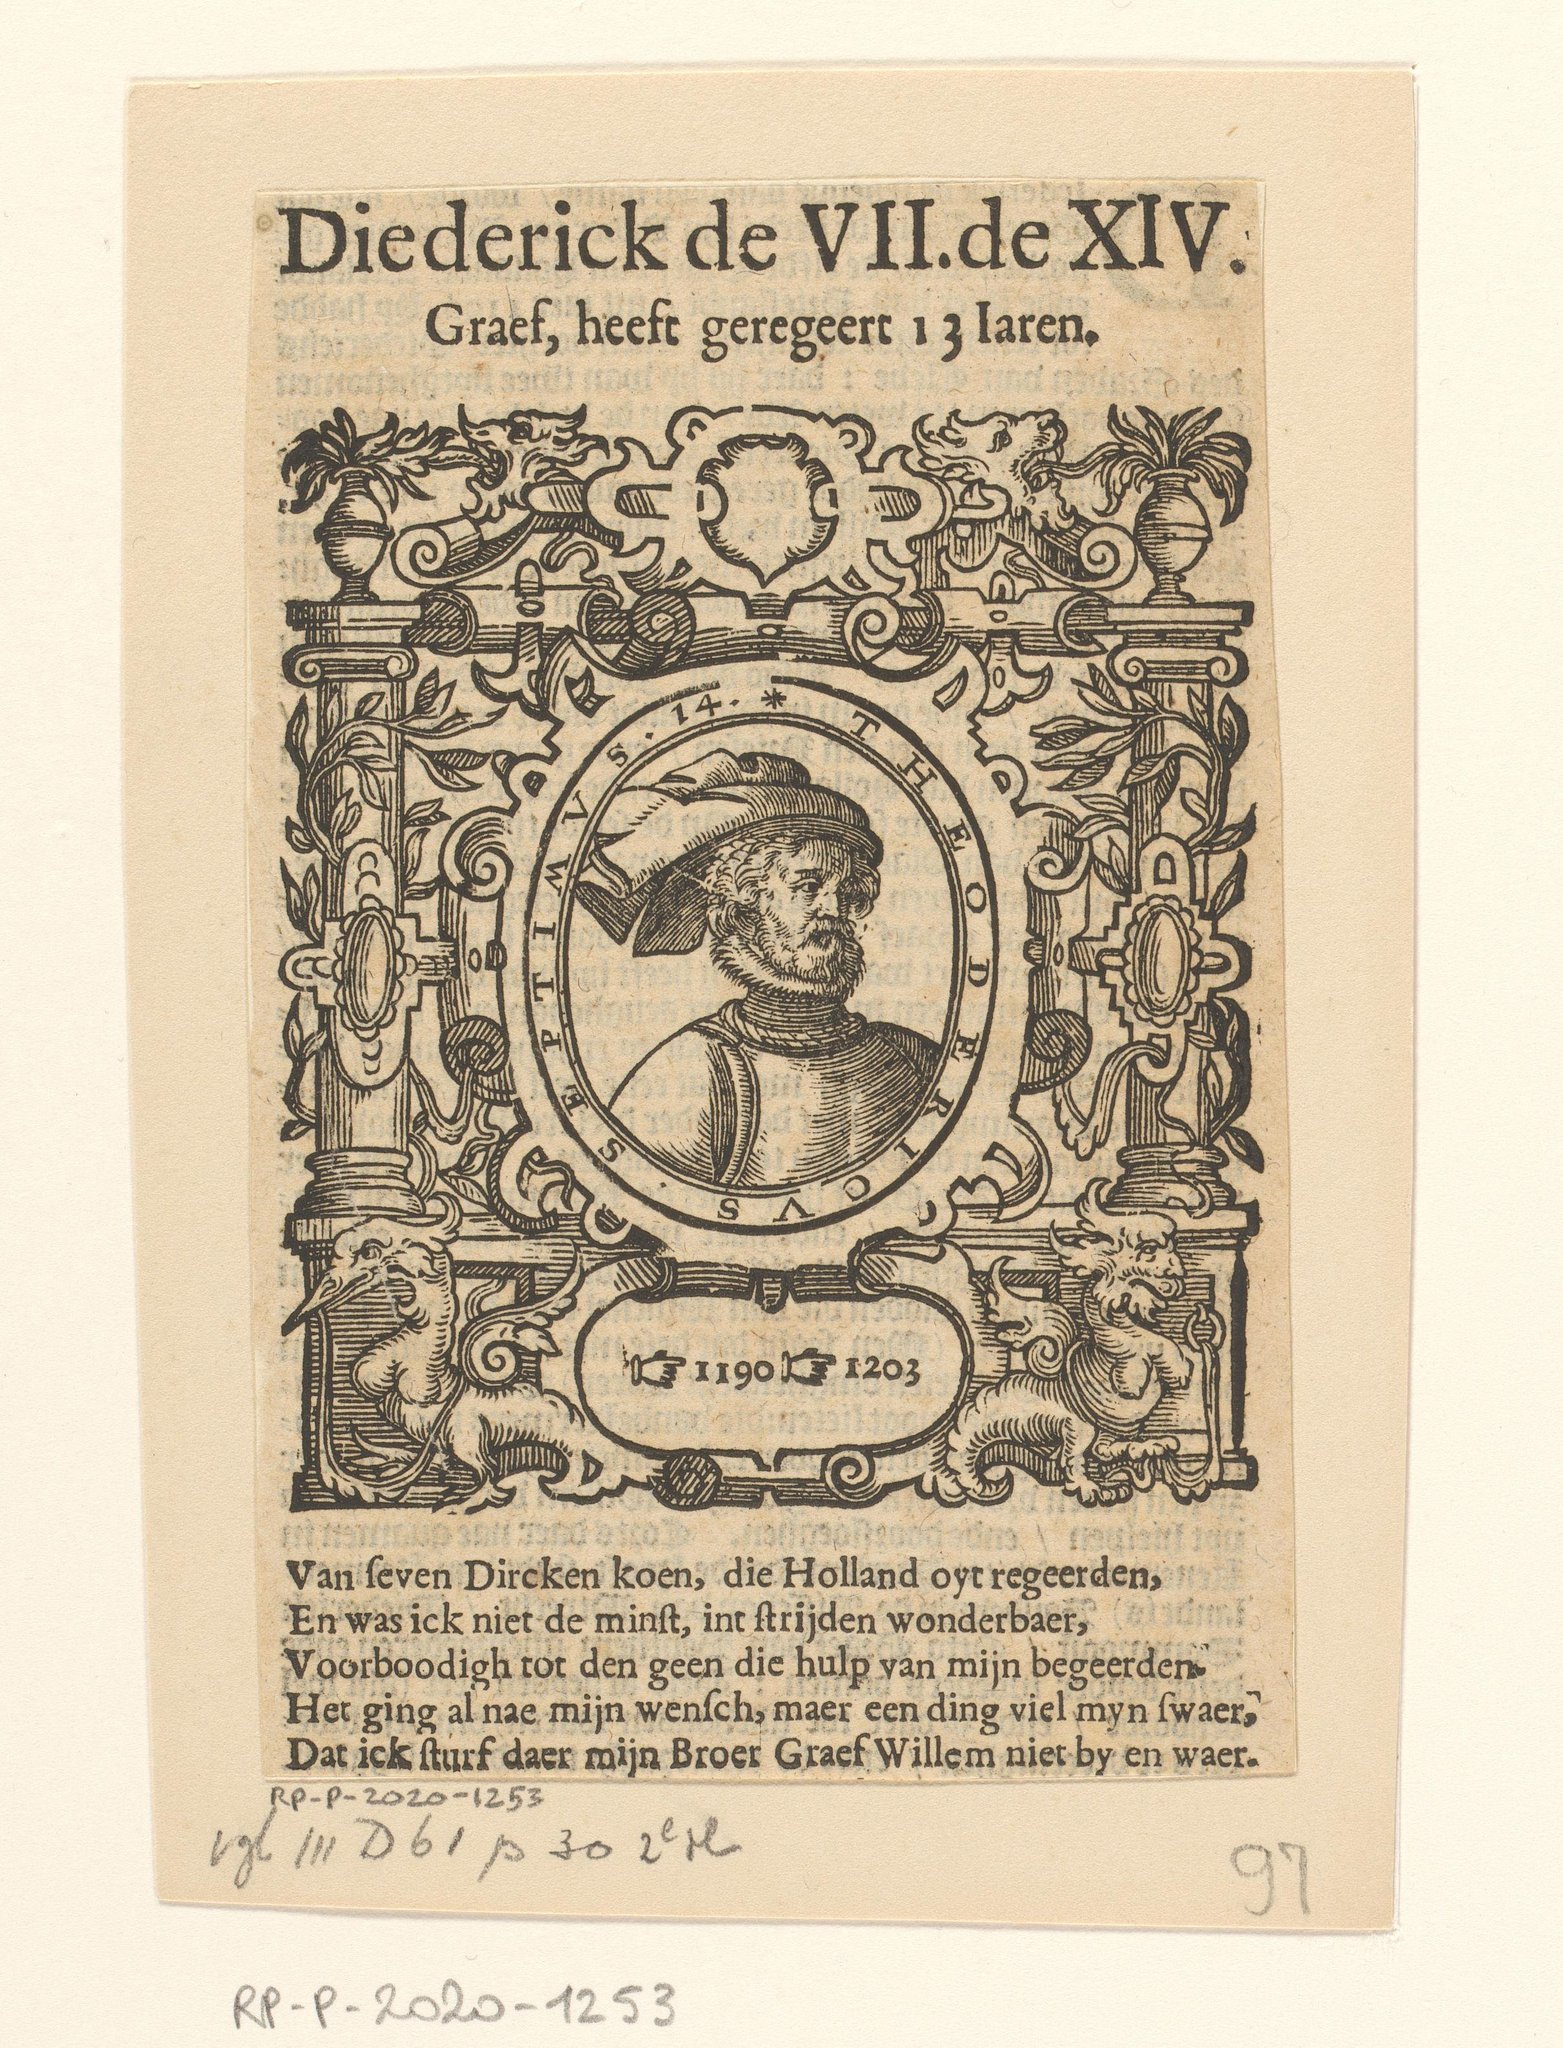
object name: print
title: Portret van Dirk VII, graaf van Holland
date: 1646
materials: paper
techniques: letterpress printing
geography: amsterdam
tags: dordrecht, historical persons, ruler, sovereign, nobility and patriciate; chivalry, knighthood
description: Prent uit: Scriverius, Petrus. Beschrivinge van out Batavien met de antiquiteyten vandien (...). Amsterdam: Broer Jansz, 1646, p. 161.